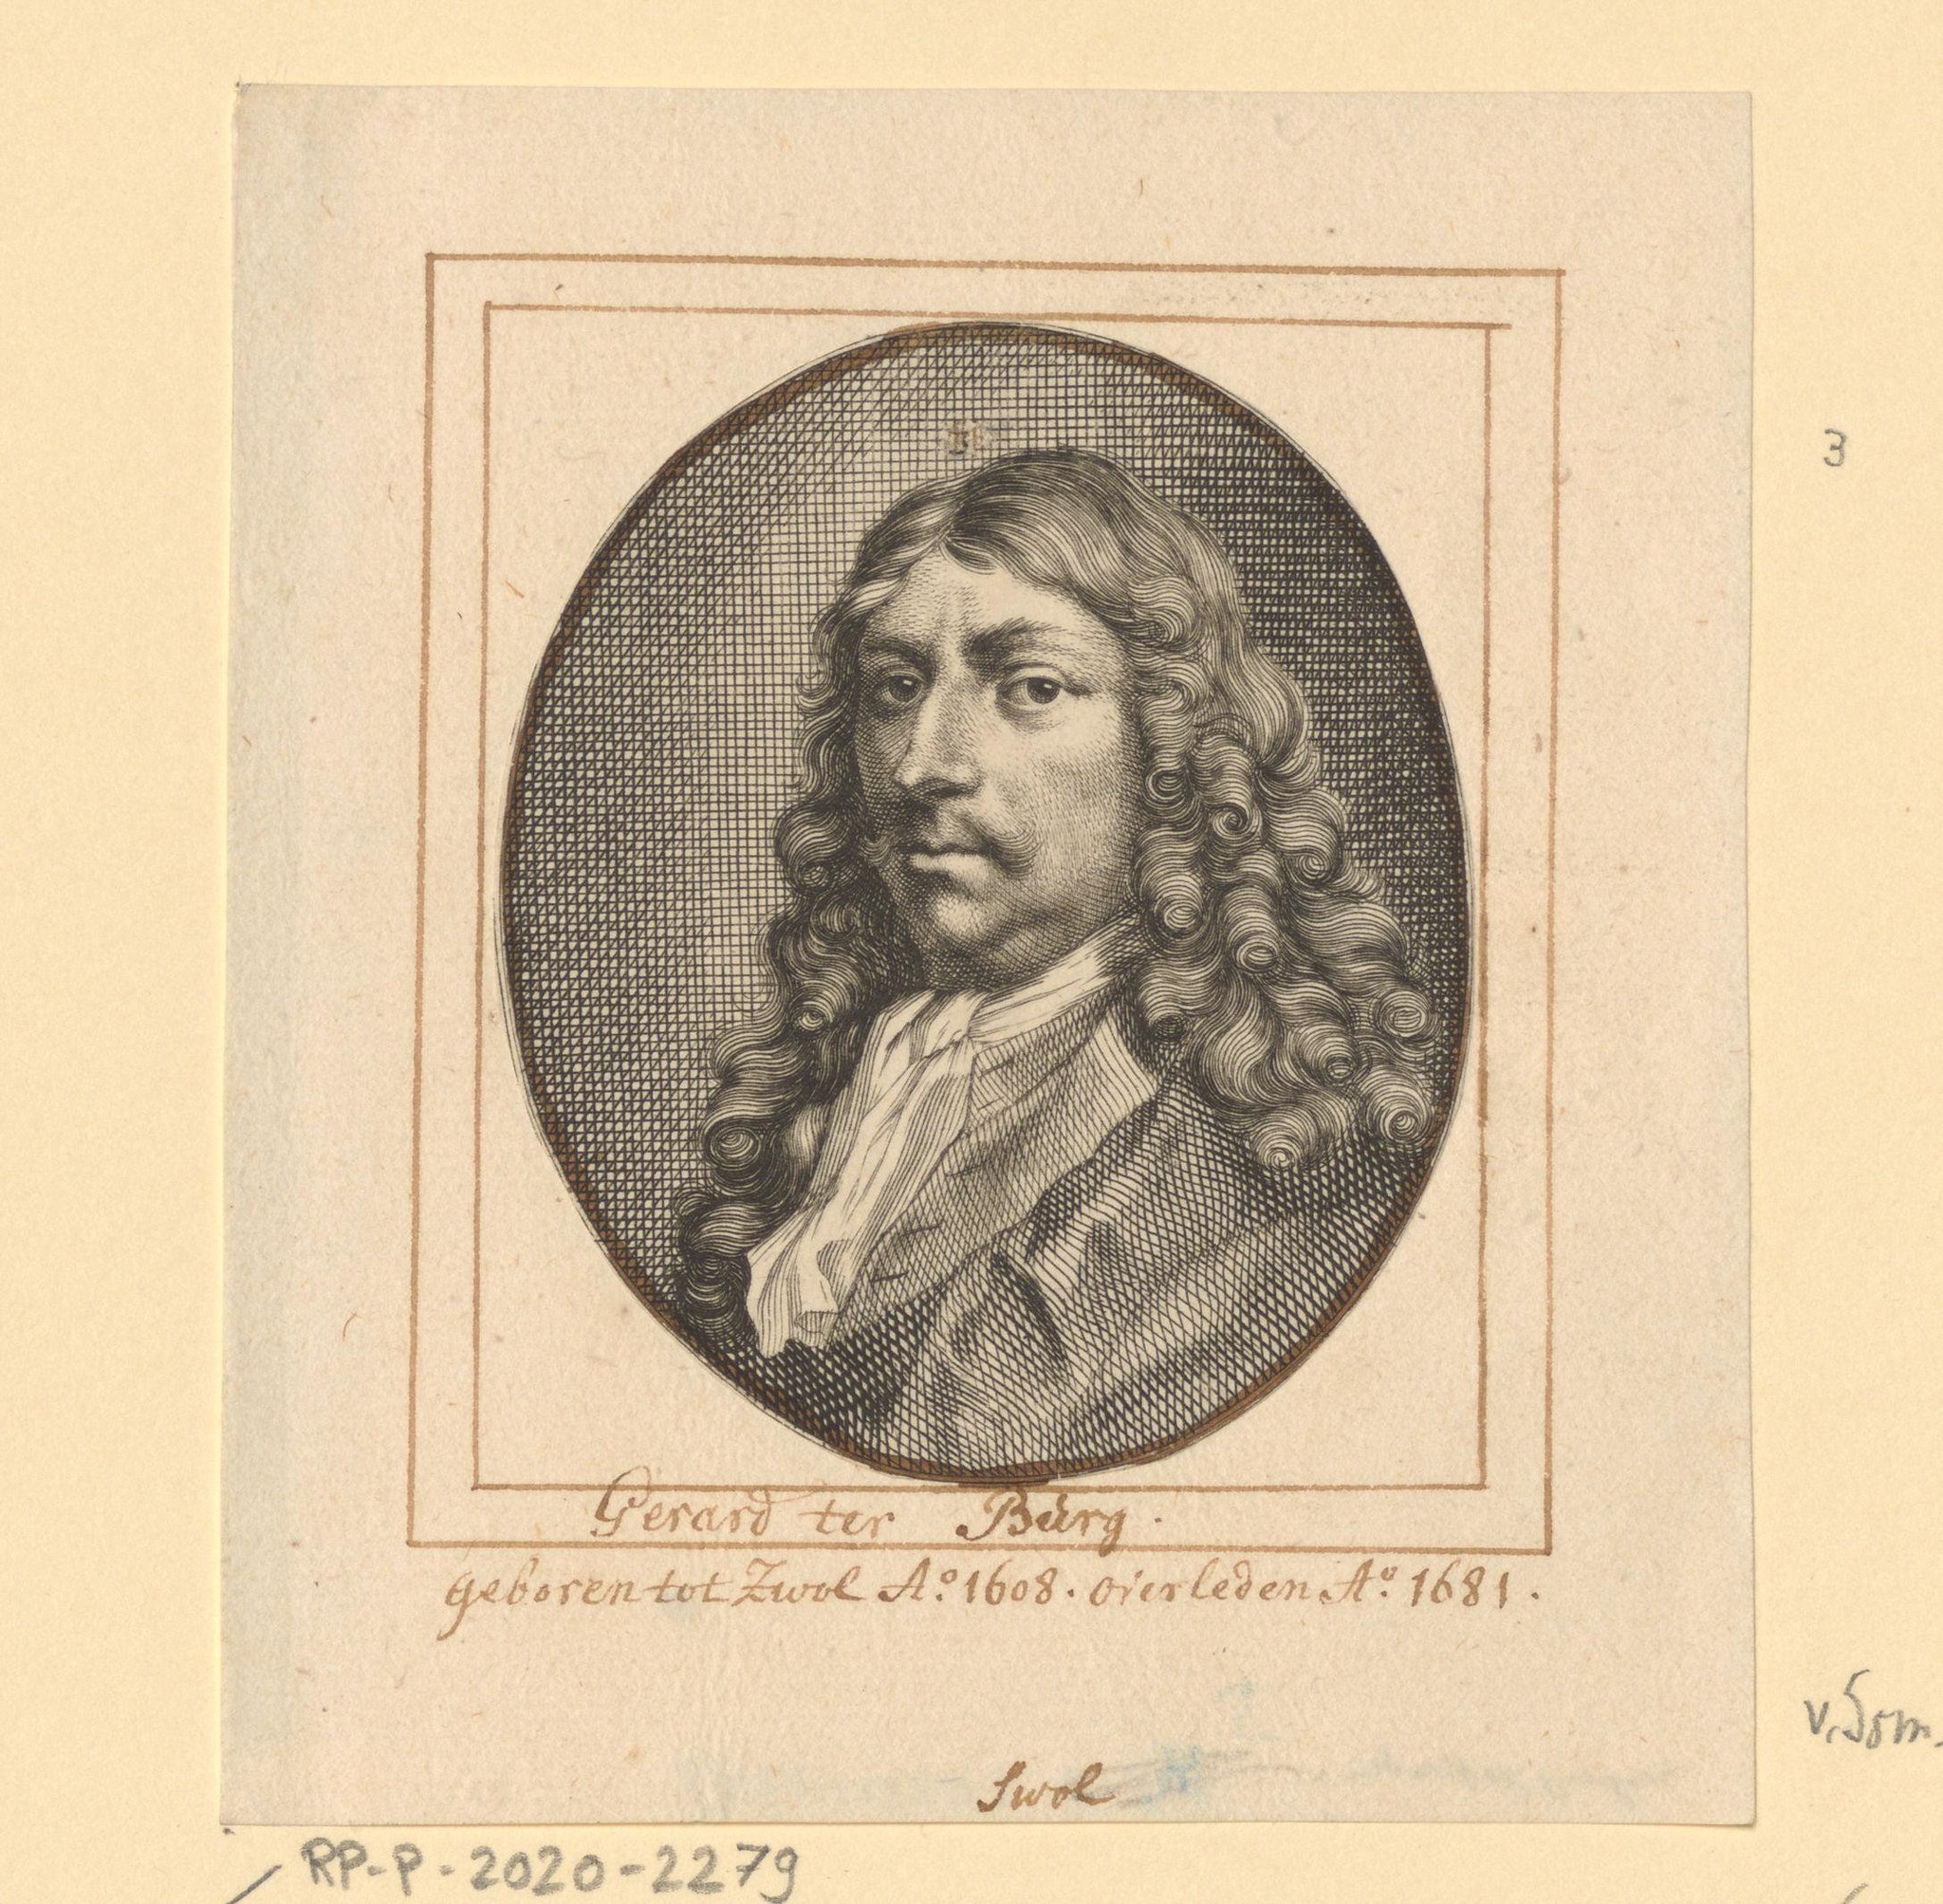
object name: book illustration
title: Portret van Gerard ter Borch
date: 1721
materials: paper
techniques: engraving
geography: amsterdam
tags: deventer, painter, gerard ter borch (ii), historical persons, portrait, self-portrait of painter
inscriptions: inscription: ‘Gerard ter Burg, geboren tot Zwol (...)’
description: Prent afkomstig uit een grotere prent uit: Houbraken, Arnold. De groote schouburgh der Nederlantsche konstschilders en schilderessen. Amsterdam: weduwe Arnold Houbraken, 1721, dl. 3.